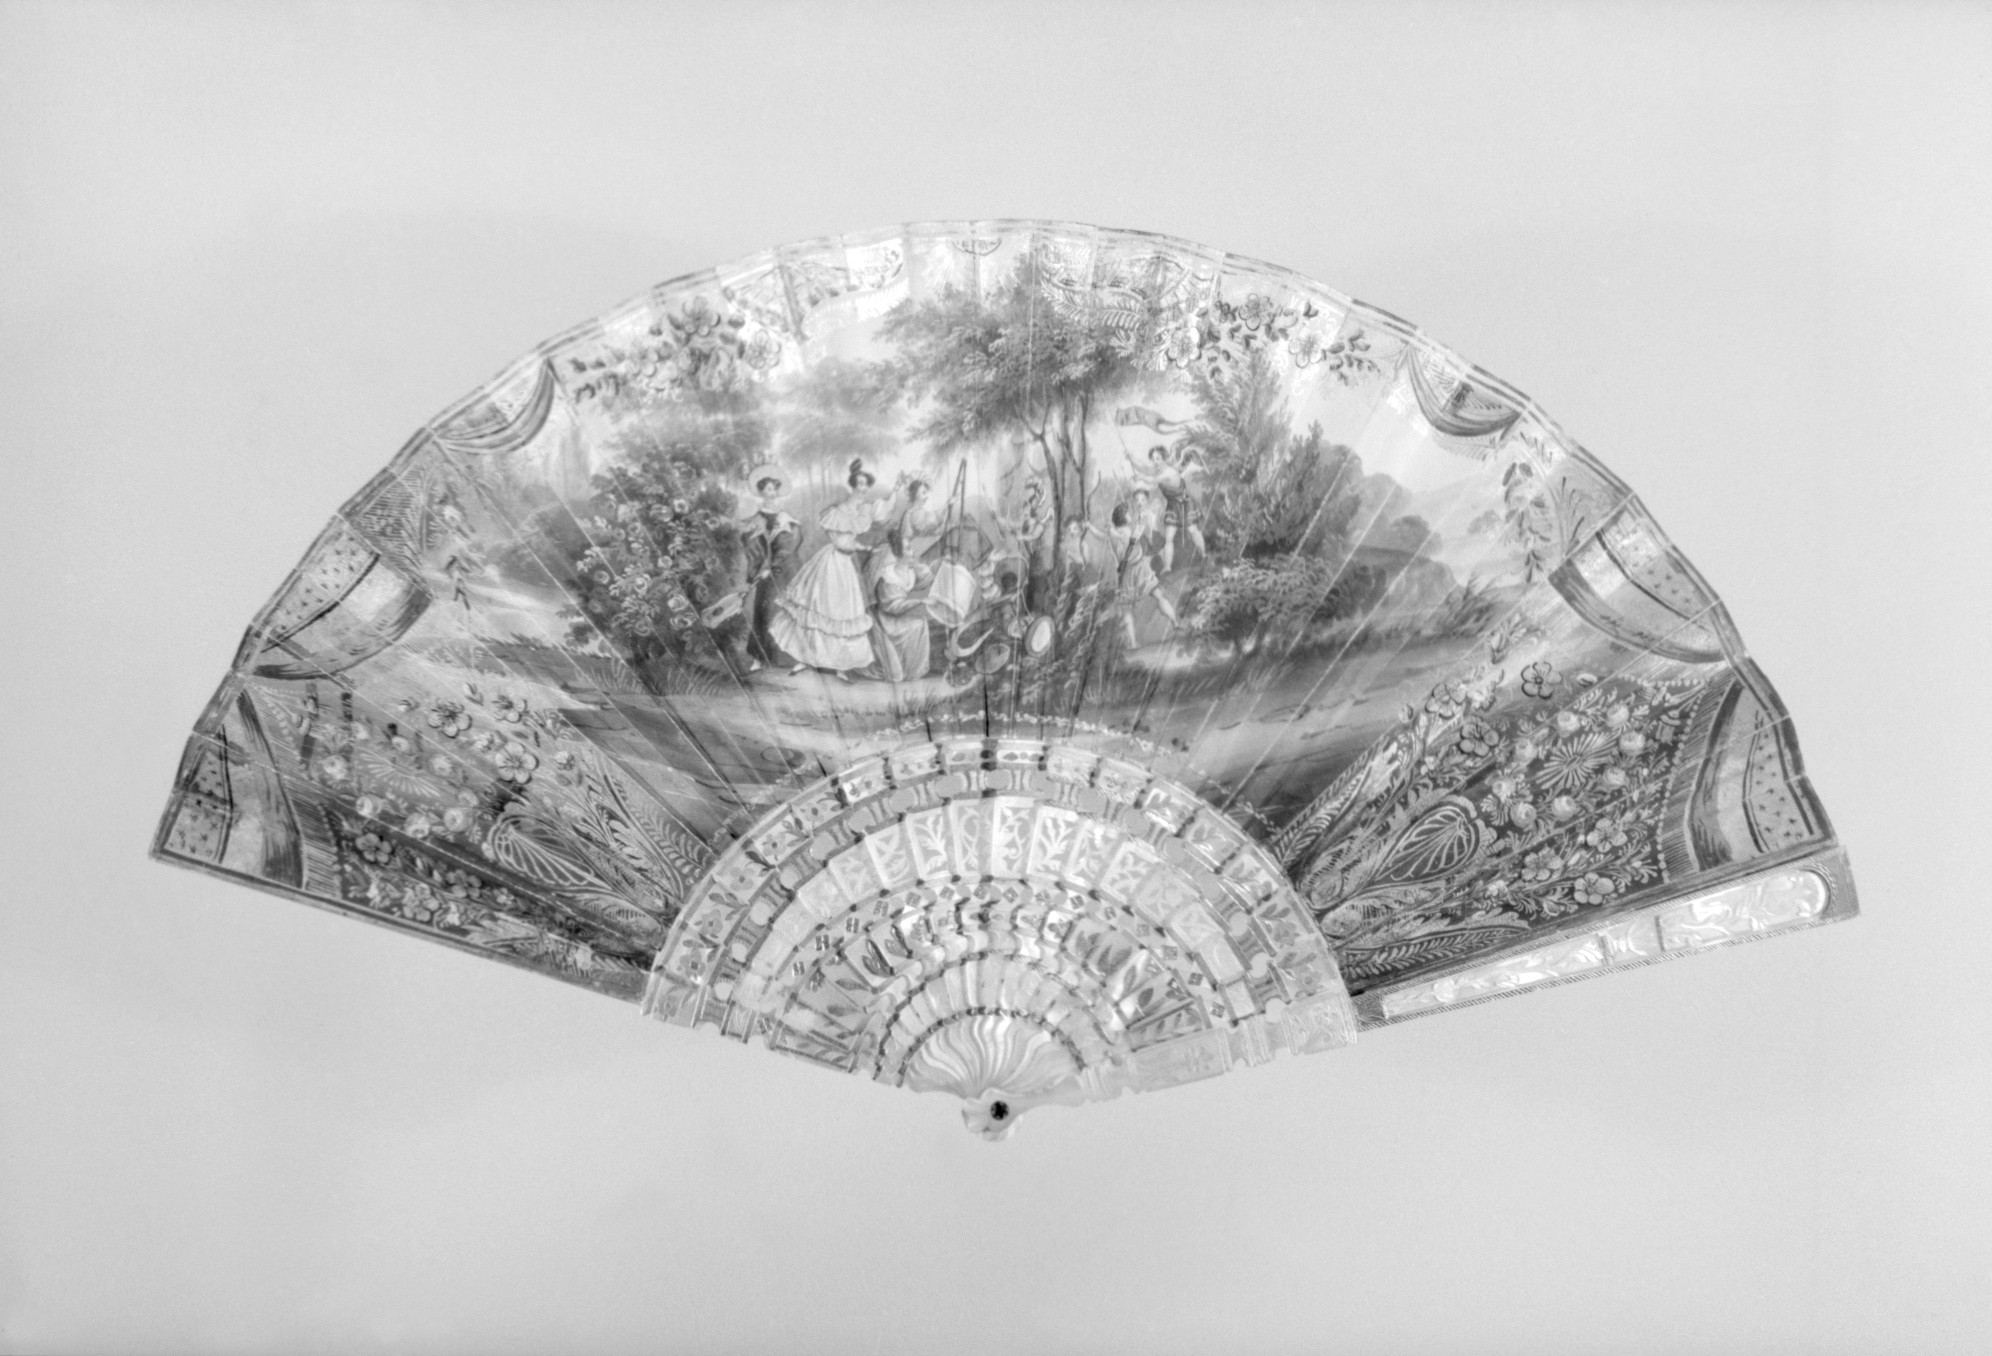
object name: fan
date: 1835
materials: gilt, glass, mother of pearl, paint, paper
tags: women